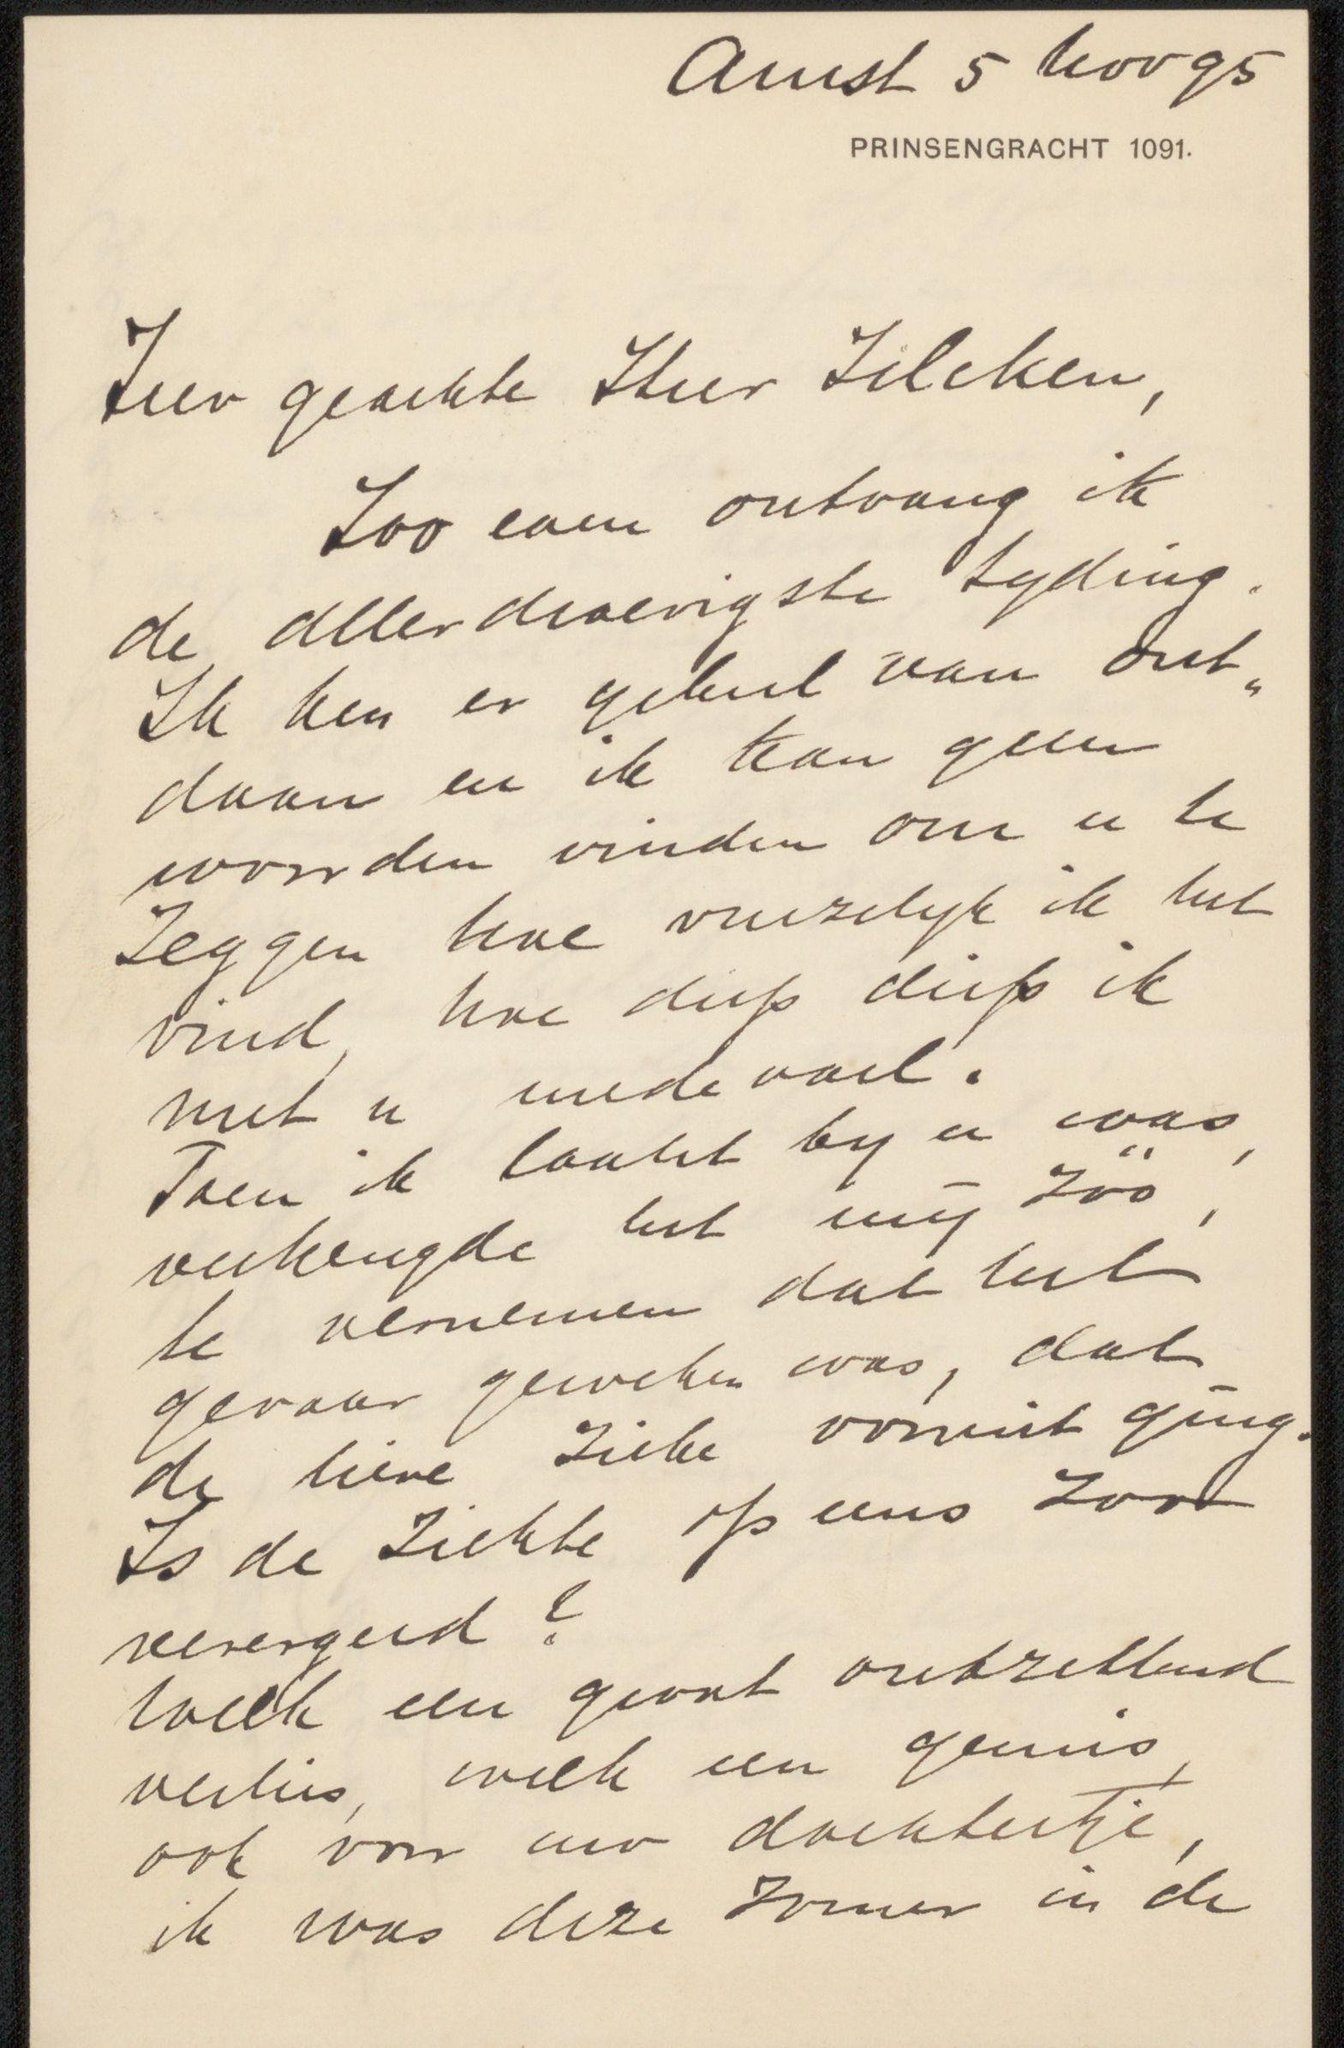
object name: letter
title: Brief aan Philip Zilcken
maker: thérèse schwartze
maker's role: draughtsman, painter, print maker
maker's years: 1851-1918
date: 1895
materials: ink, paper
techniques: pen, writing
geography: amsterdam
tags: voorburg, print maker, renée hélène laure zilcken, brussels, helène lambertine hauzeur, the hague, painter, draughtsman, philip zilcken, passions, emotions, affections, diseases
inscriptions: watermark